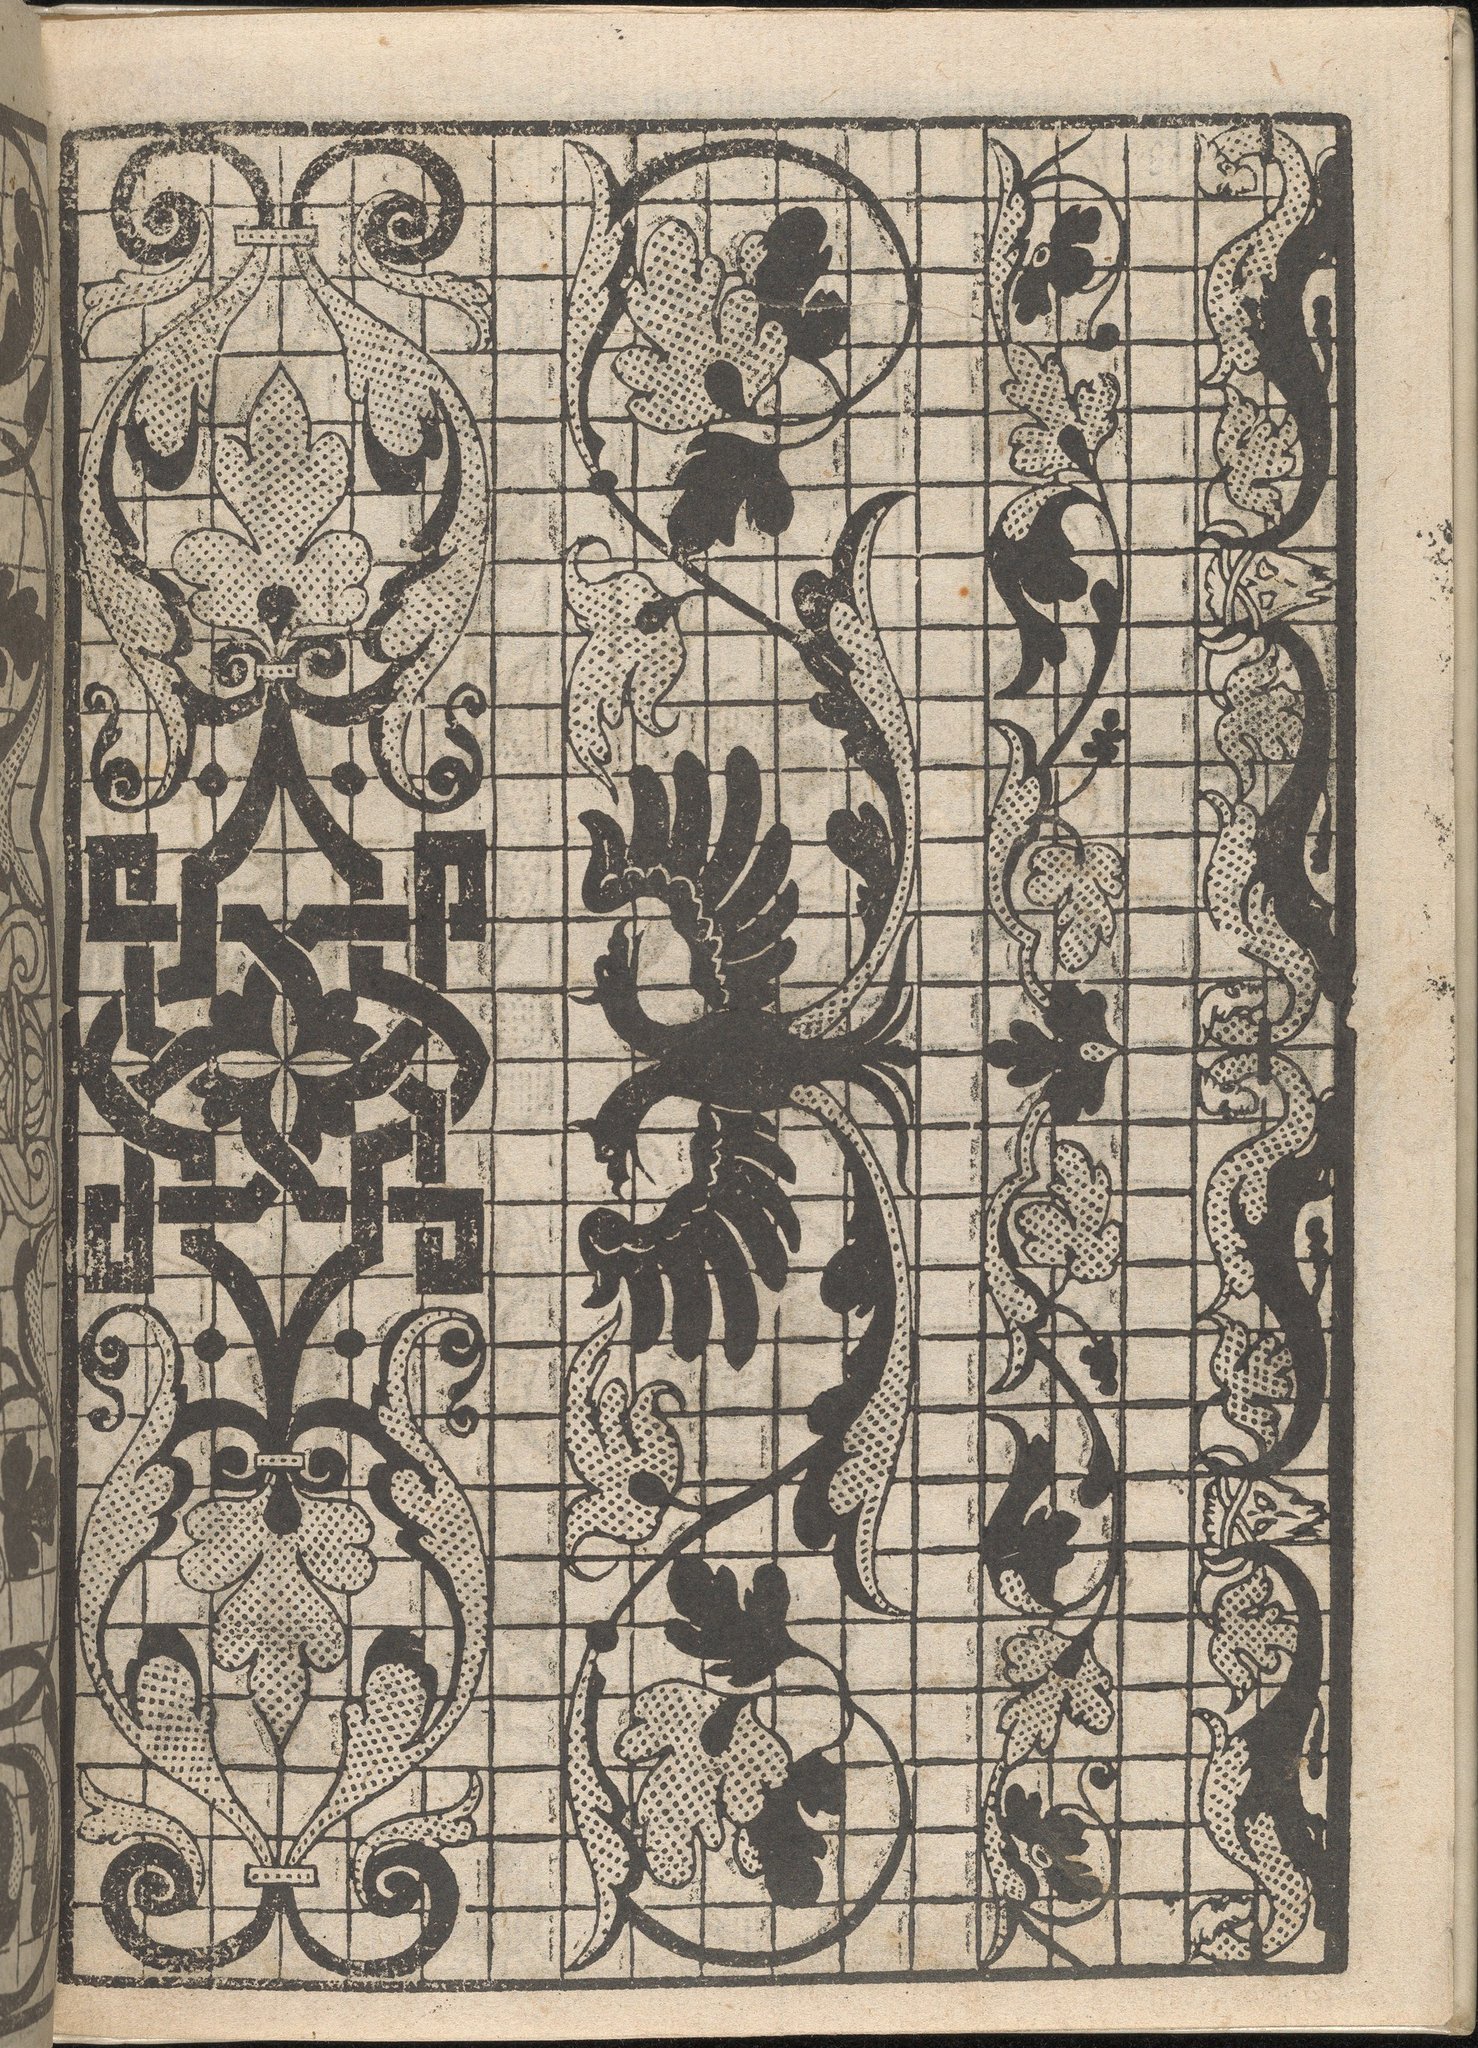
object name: book print ornament architecture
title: Splendore delle virtuose giovani, page 15 (recto)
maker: iseppo foresto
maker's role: designer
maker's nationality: italian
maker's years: 1520-1580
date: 1564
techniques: woodcut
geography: italy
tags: eagles,ornament